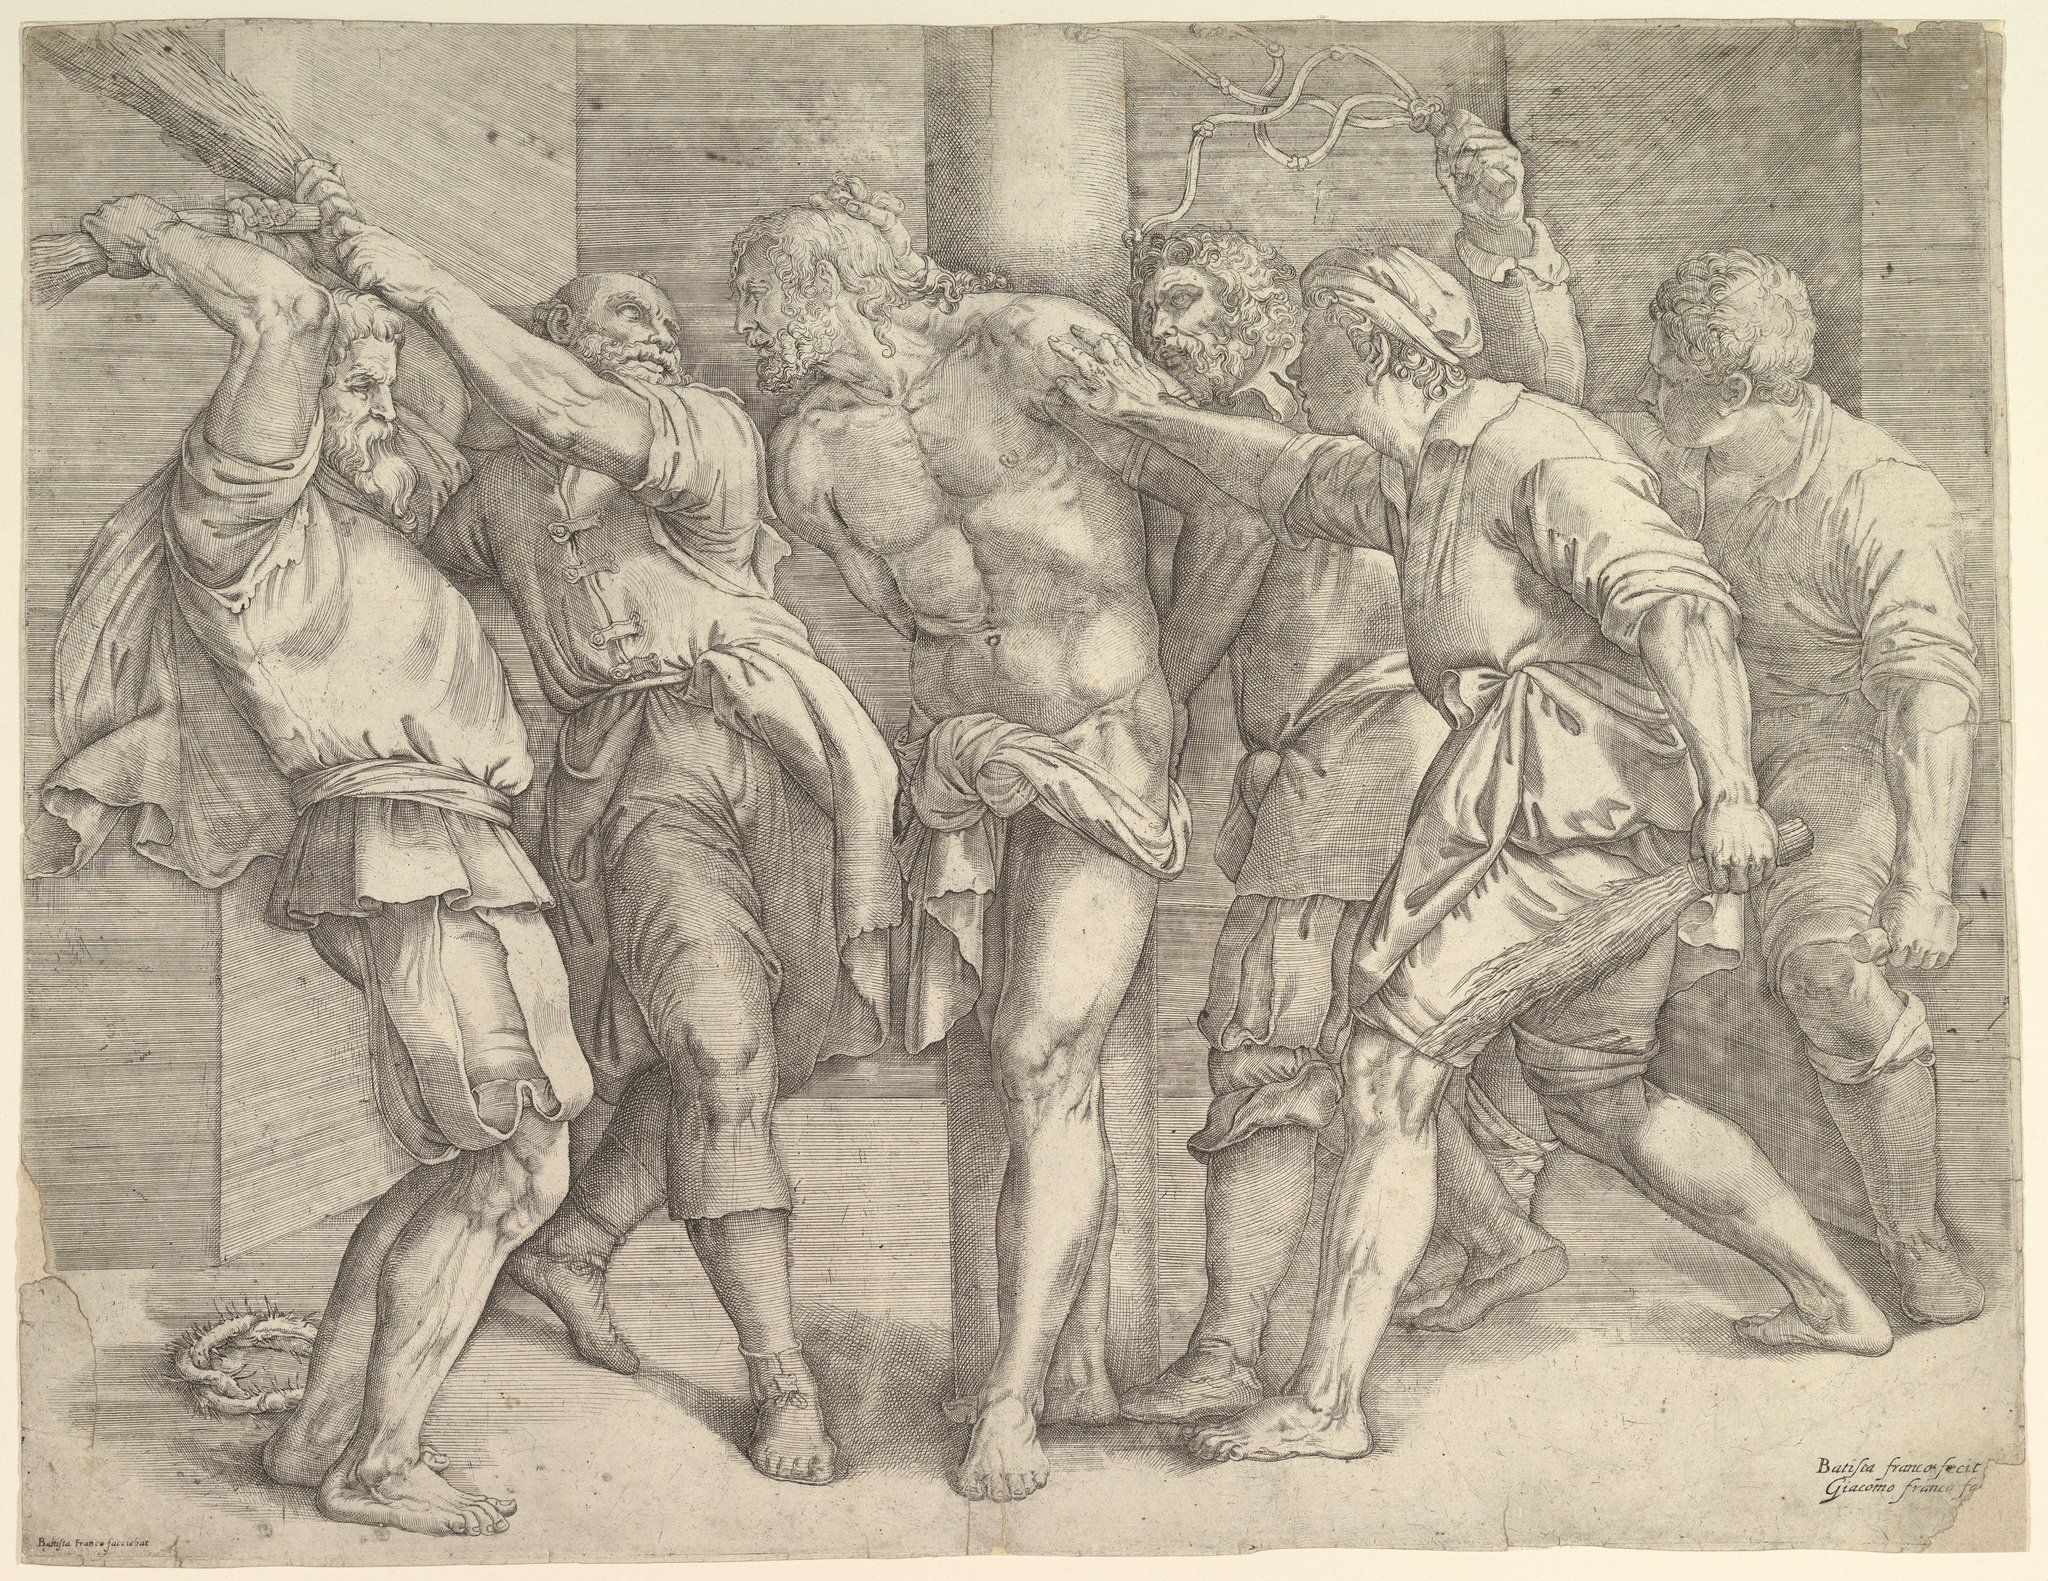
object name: print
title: The Flagellation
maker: battista franco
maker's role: artist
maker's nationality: italian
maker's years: 1510-1561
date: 1552-1561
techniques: engraving, etching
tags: men,christ